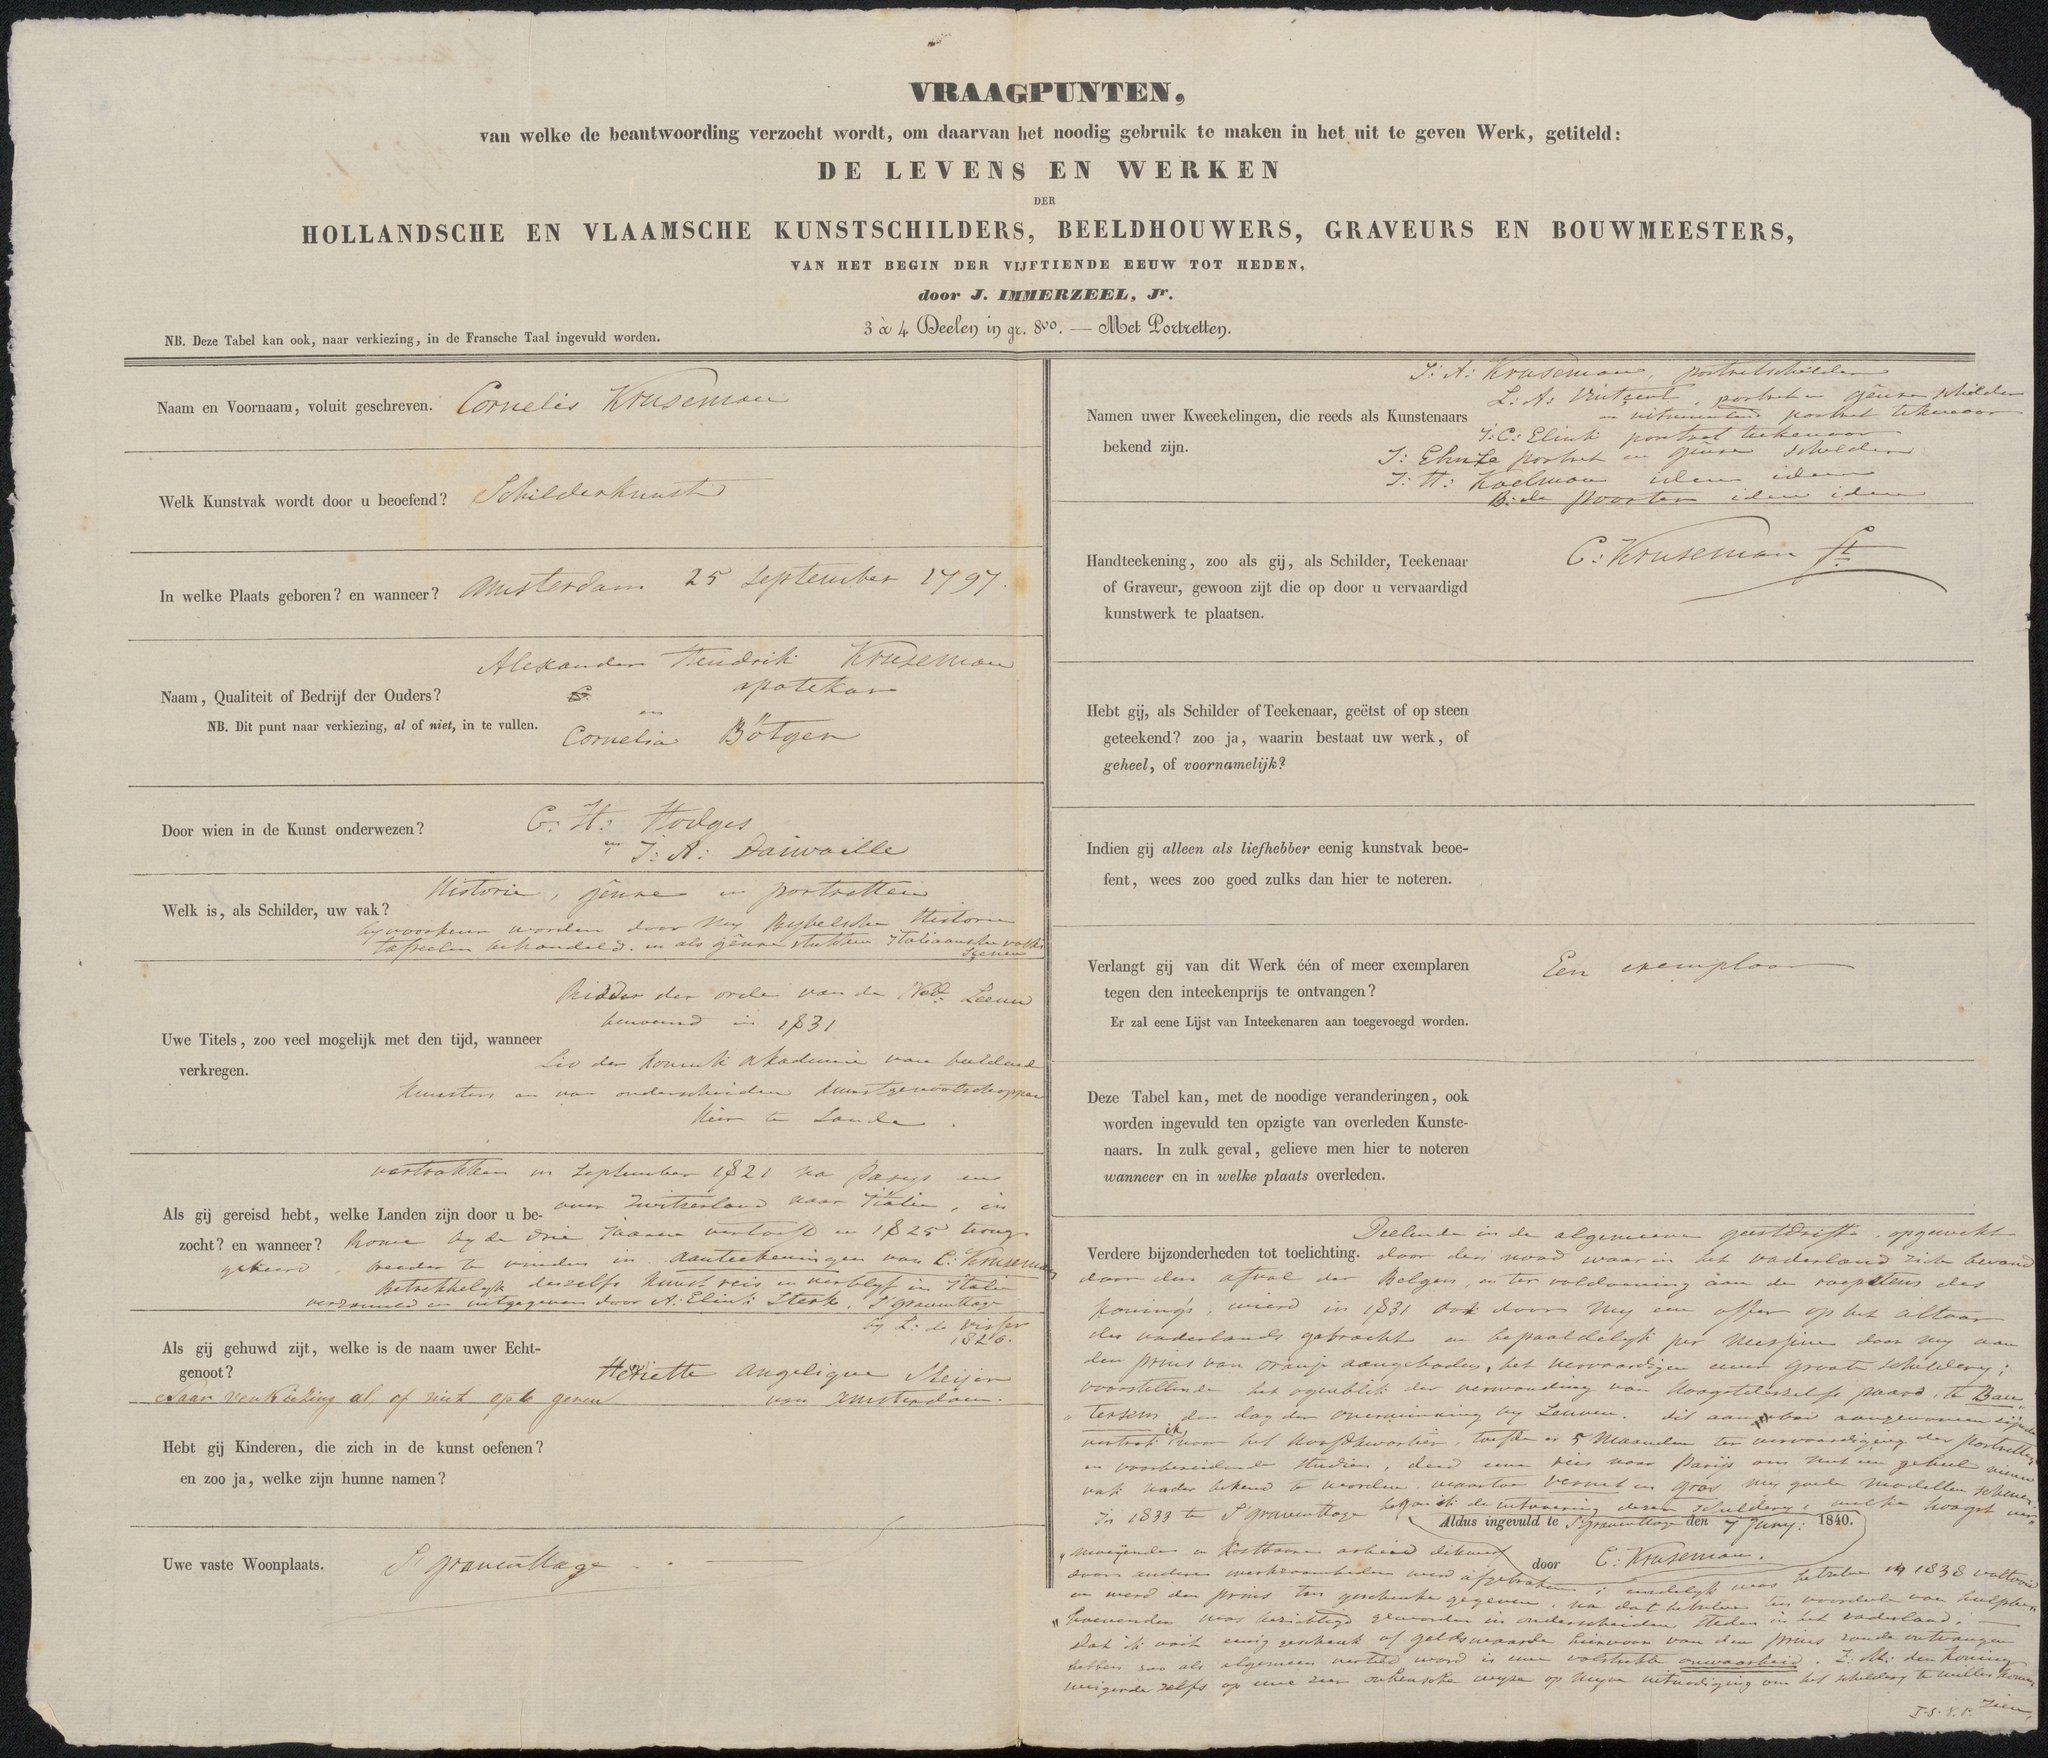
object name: questionnaire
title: Enquêteformulier ingevuld door Cornelis Kruseman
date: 1840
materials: ink, paper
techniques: pen, printing, writing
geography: the hague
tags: amsterdam, painter, print maker, draughtsman, cornelis kruseman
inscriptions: inscription: ‘Vraagpunten,/ van welke de beantwoording verzocht wordt, om daarvan het noodig gebruik te maken in het uit te geven Werk, getiteld: De levens en werken/ der Hollandsche en Vlaamsche kunstschilders, beeldhouwers,/ graveurs en bouwmeesters, van het begin der vijftiende eeuw tot heden/ door J. Immerzeel, Jr.’, watermark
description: Opgenomen in: Immerzeel, J. Jr., De levens en werken der Hollandsche en Vlaamsche kunstschilders, beeldhouwers, graveurs en bouwmeesters, van het begin der vijftiende eeuw tot heden, Amsterdam: J.C. van Kesteren, 1842-1843.